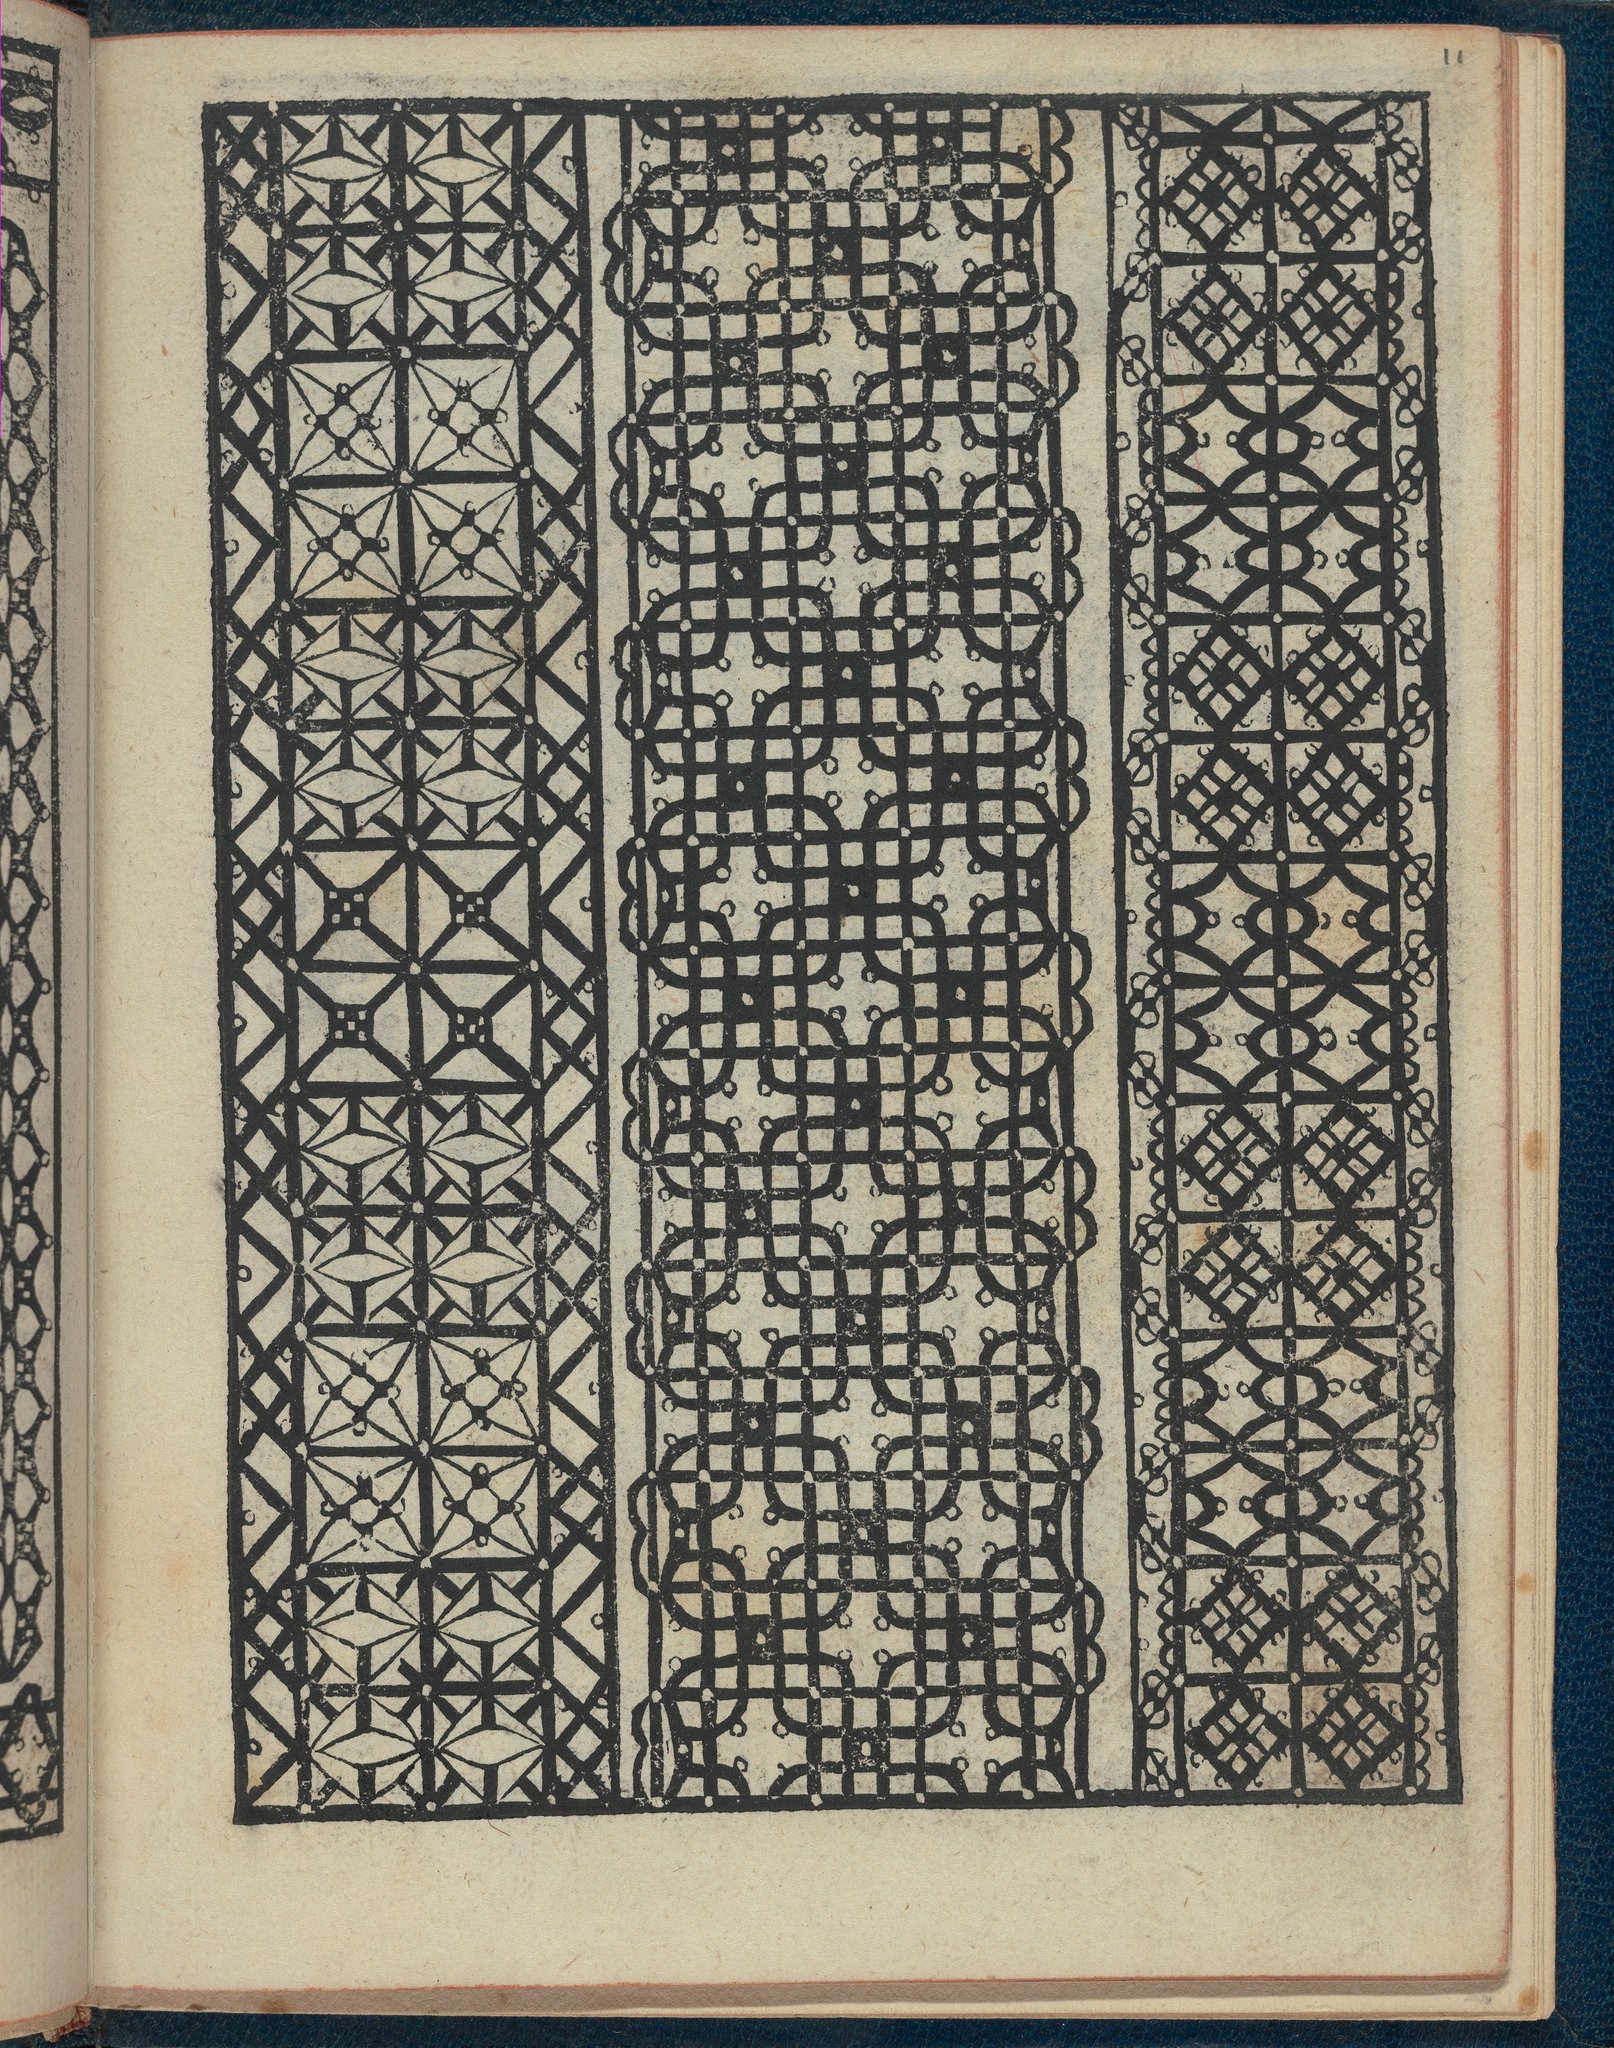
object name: book print ornament architecture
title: Le Pompe: Opera Nova, page 6 (recto)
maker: giovanni battista & marchio sessa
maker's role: publisher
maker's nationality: italian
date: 1557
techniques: woodcut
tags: ornament